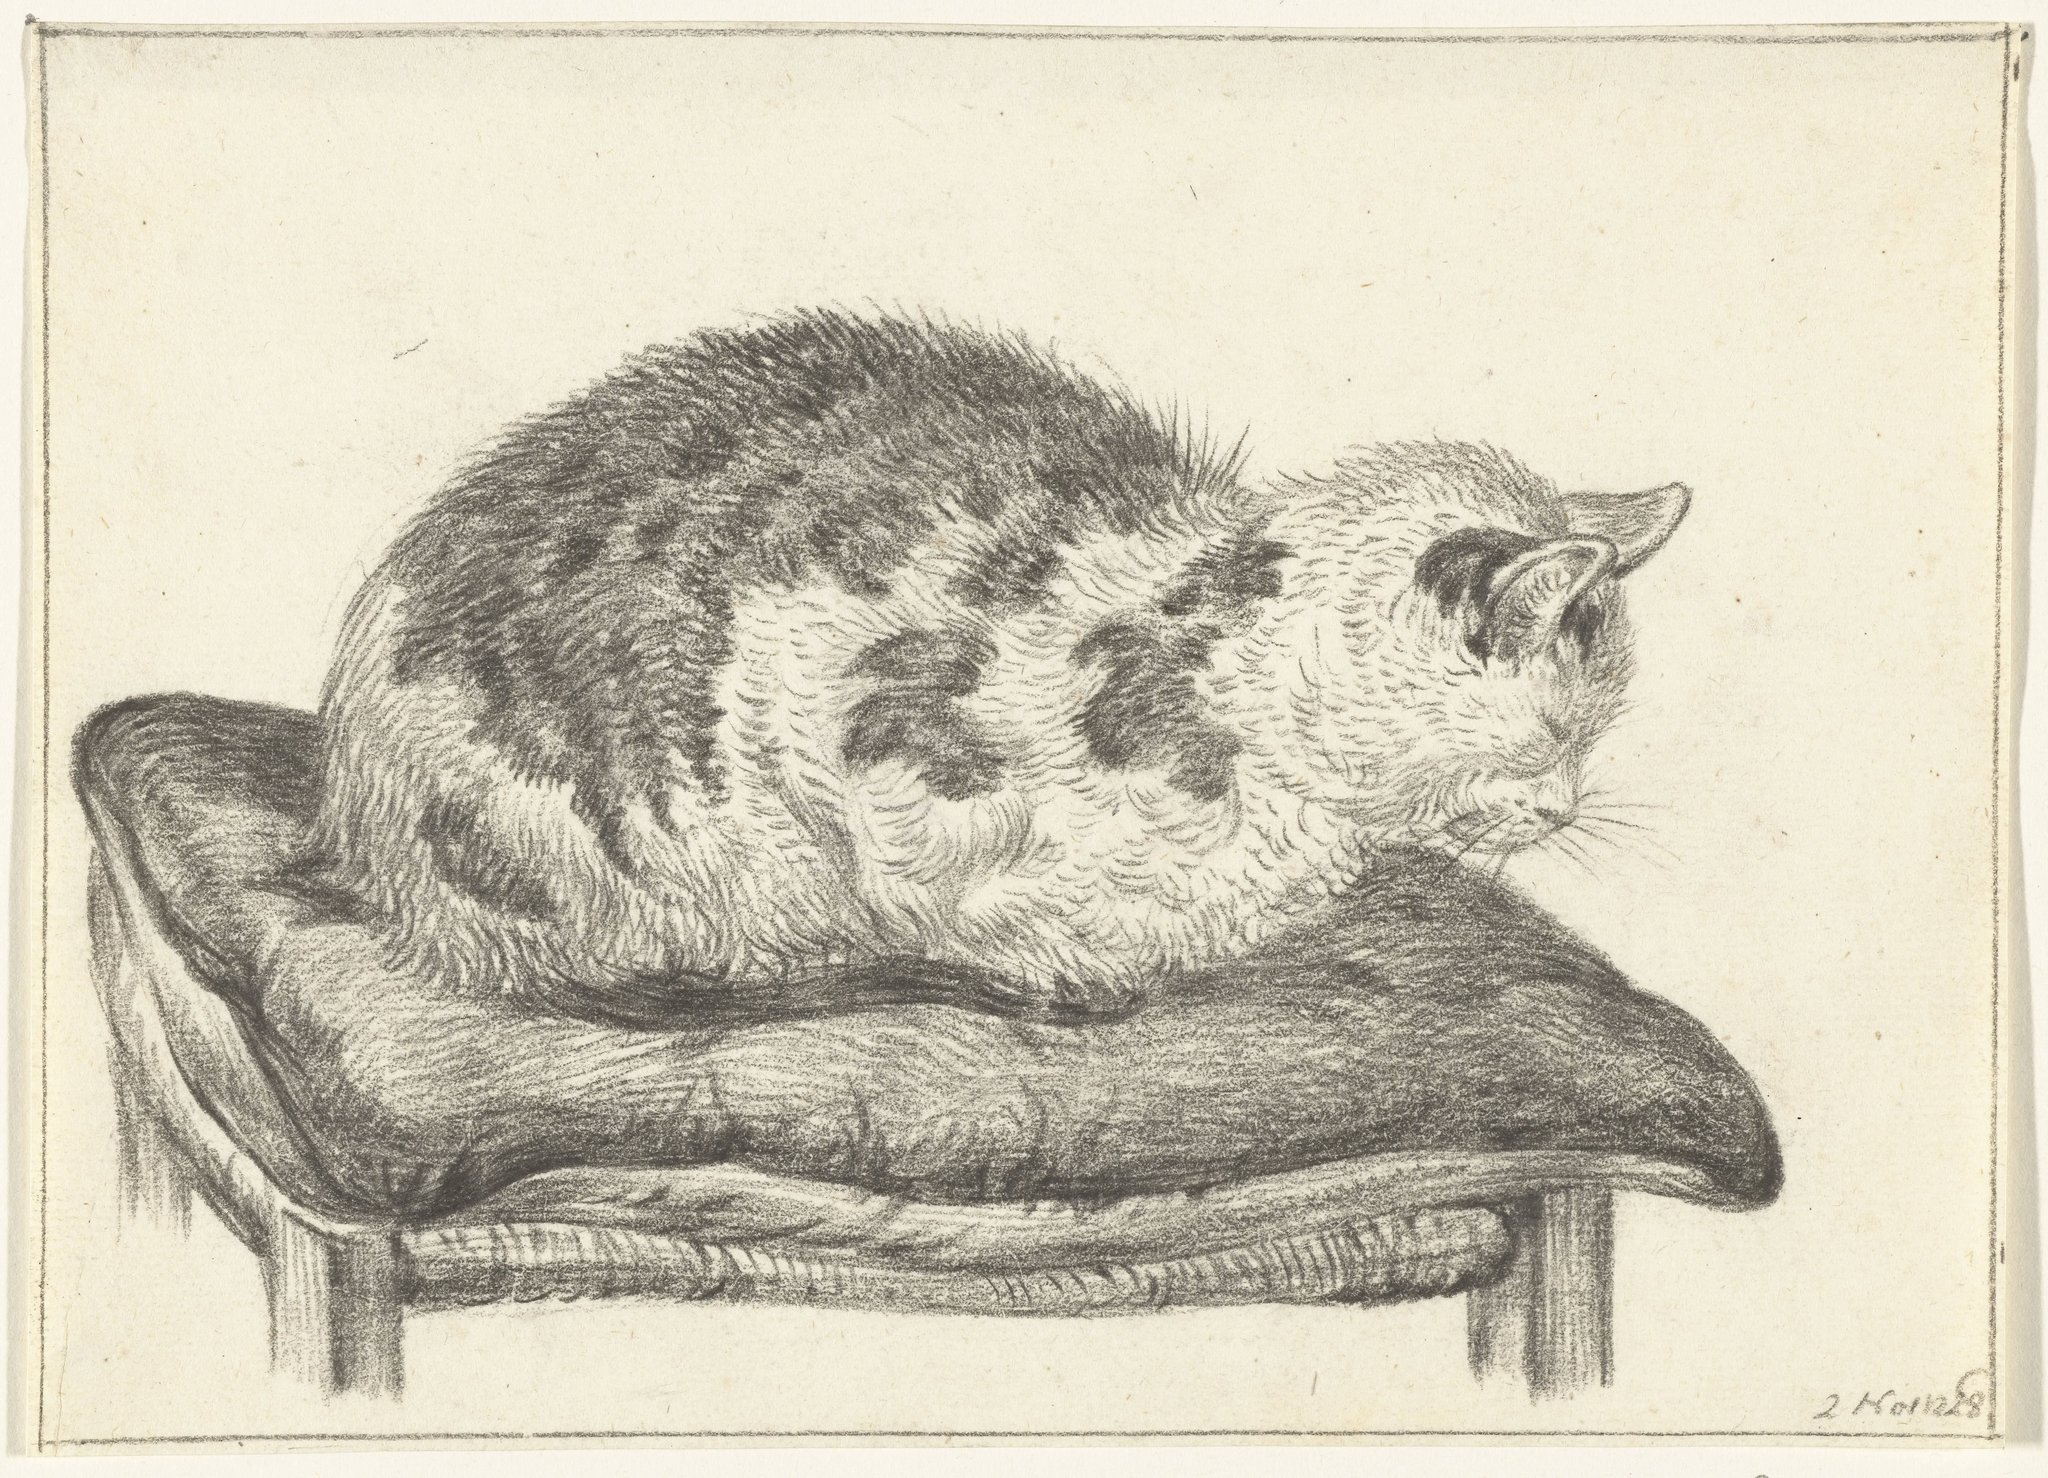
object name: drawing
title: Liggende kat, op een kussen, naar links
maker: jean bernard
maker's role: draughtsman, print maker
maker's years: 1765-1833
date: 1828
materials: chalk, paper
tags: cat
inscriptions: date: ‘2 Nov 1828’